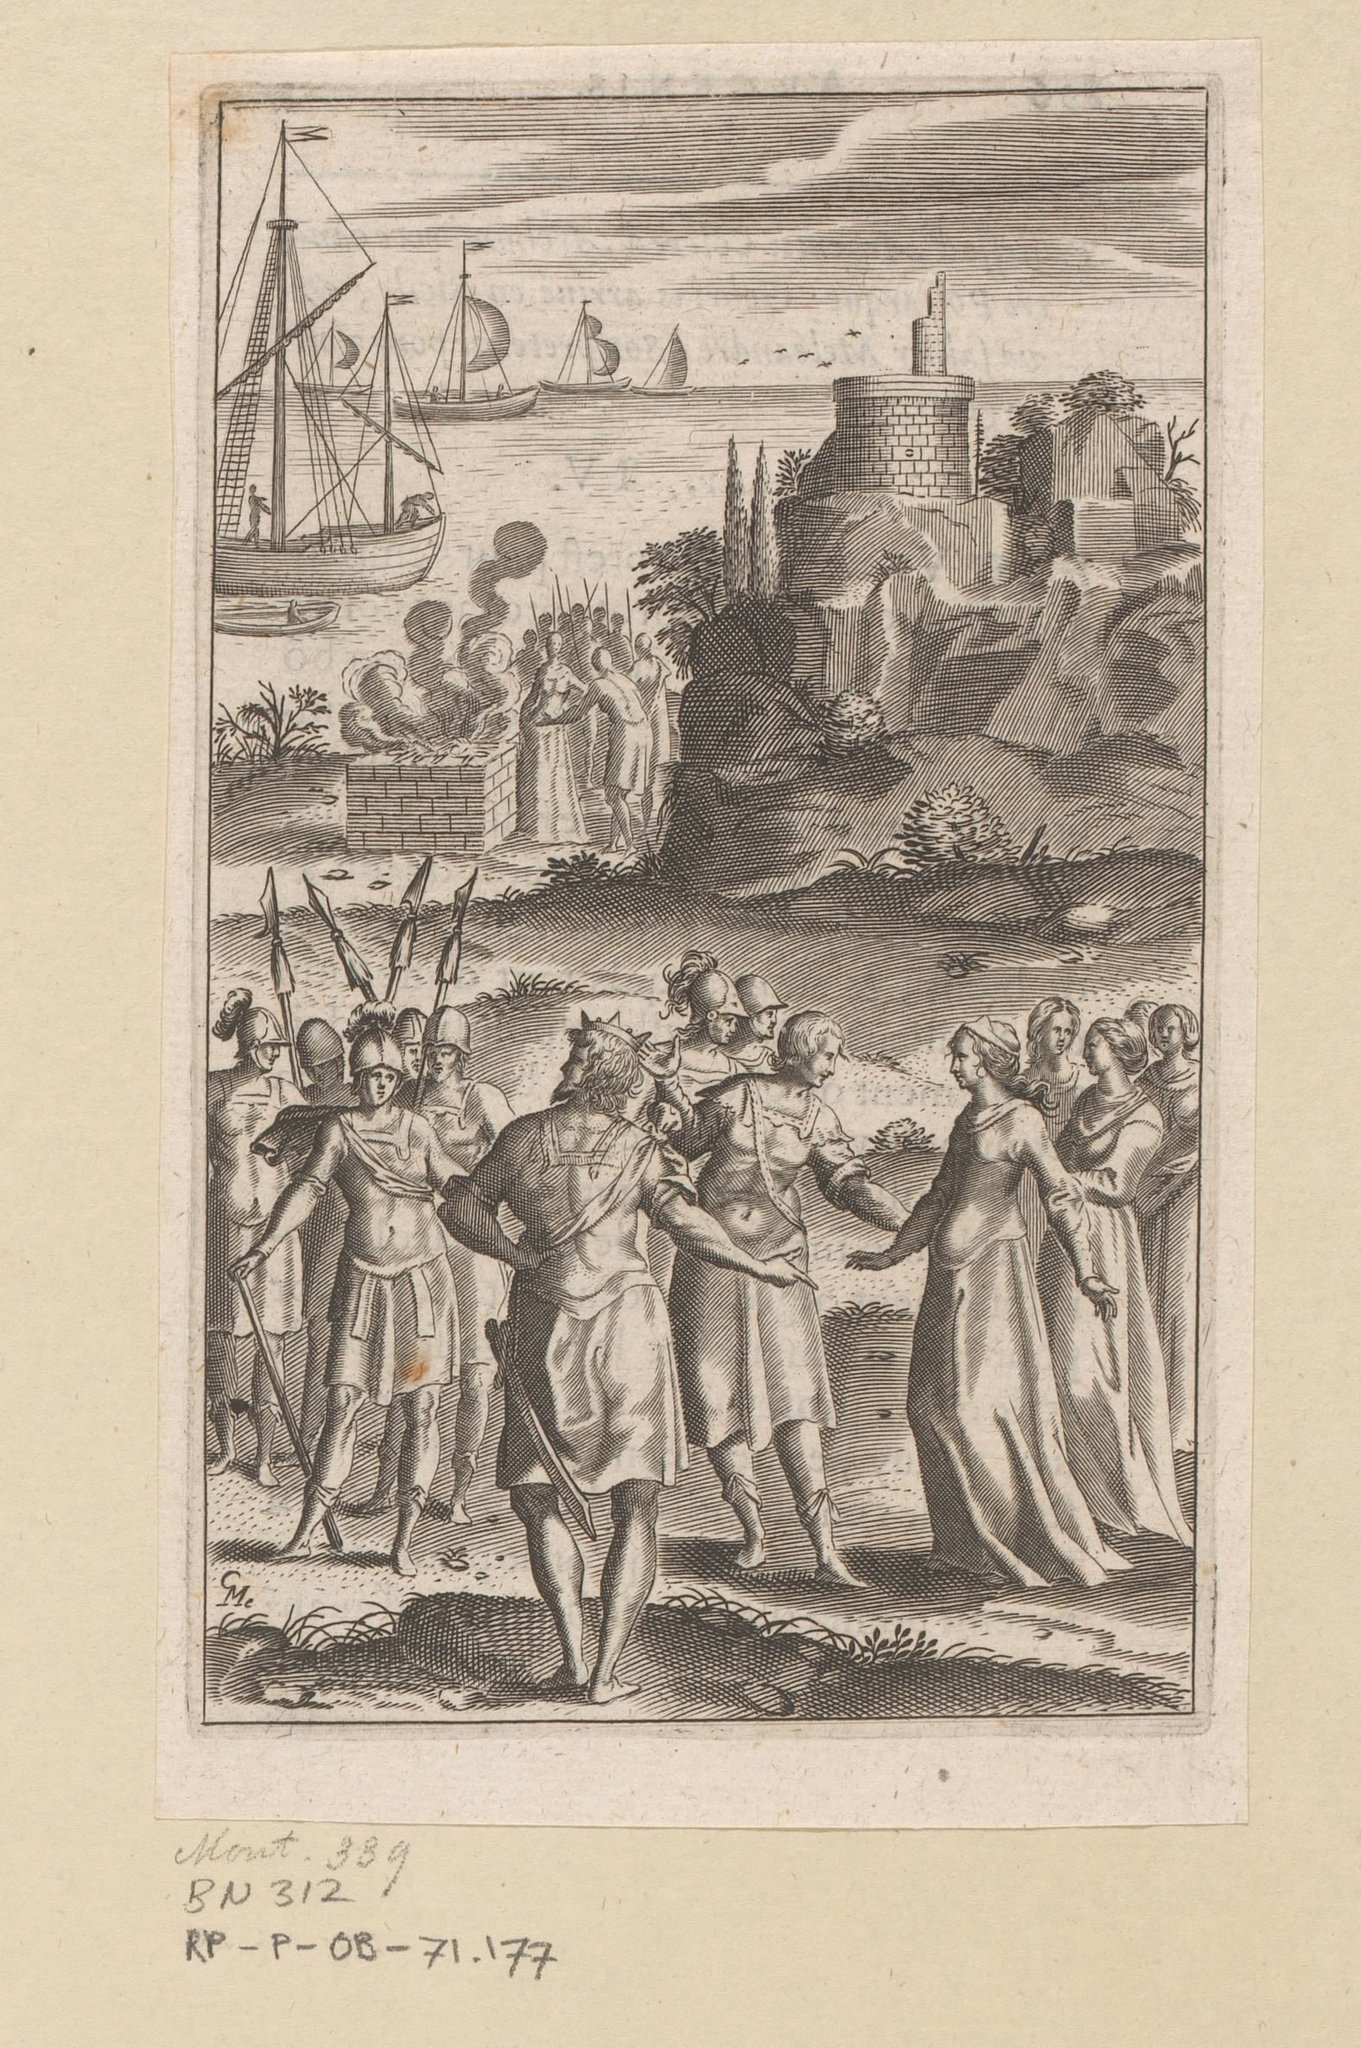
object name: book illustration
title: Gobrias groet koning Meleander en zijn dochter Argenis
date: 1624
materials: paper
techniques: engraving, letterpress printing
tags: king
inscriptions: collector's mark: Lugt 240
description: Prent uit: Barclay, Jean. L'Argenis. Traduction nouvelle enrichie de figures. Parijs: Nicolas Buon, 1624, dl. 5, hoofdstuk 4. In 1625 werd een tweede editie uitgegeven, eveneens door Nicolas Buon en in 1636 werd een Engelse vertaling uitgegeven door Henry Seile in Londen.